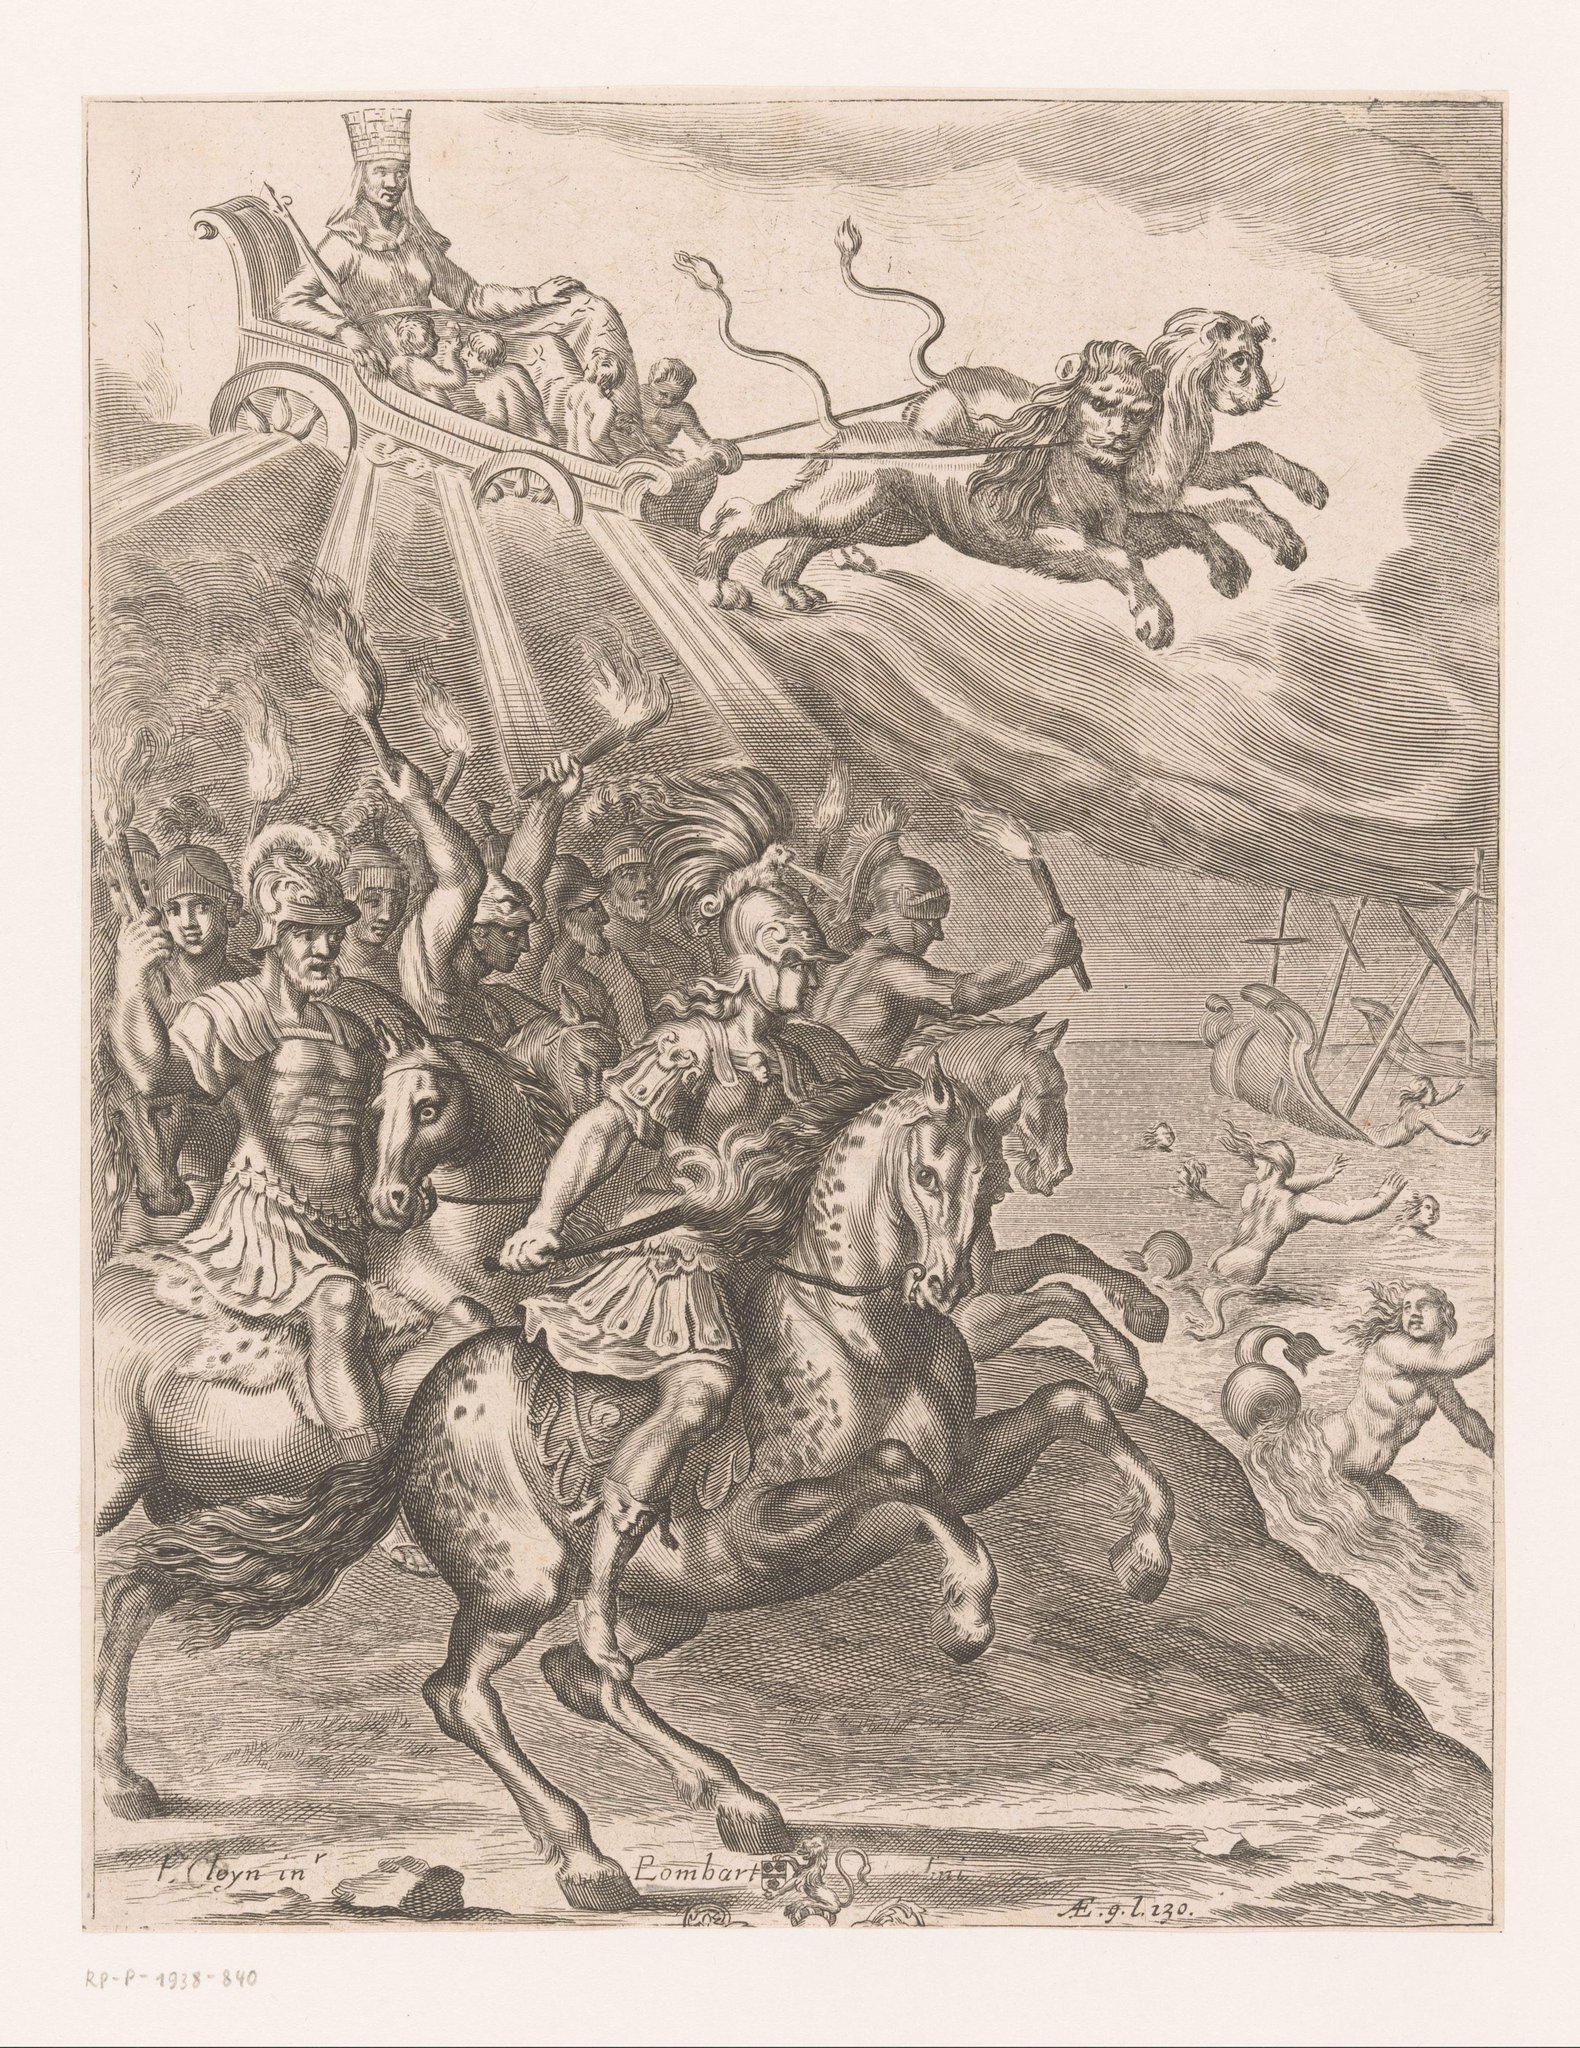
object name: print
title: Ruiters met toortsen drijven zeewezens verder in de zee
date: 1654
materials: paper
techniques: engraving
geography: london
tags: riding a horse, ass, or mule; rider, horseman, sea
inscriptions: collector's mark: Lugt 2228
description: Waarschijnlijk prent uit: Ogilby, John. The works of Publius Virgilius Maro. Londen: s.n; 1654.